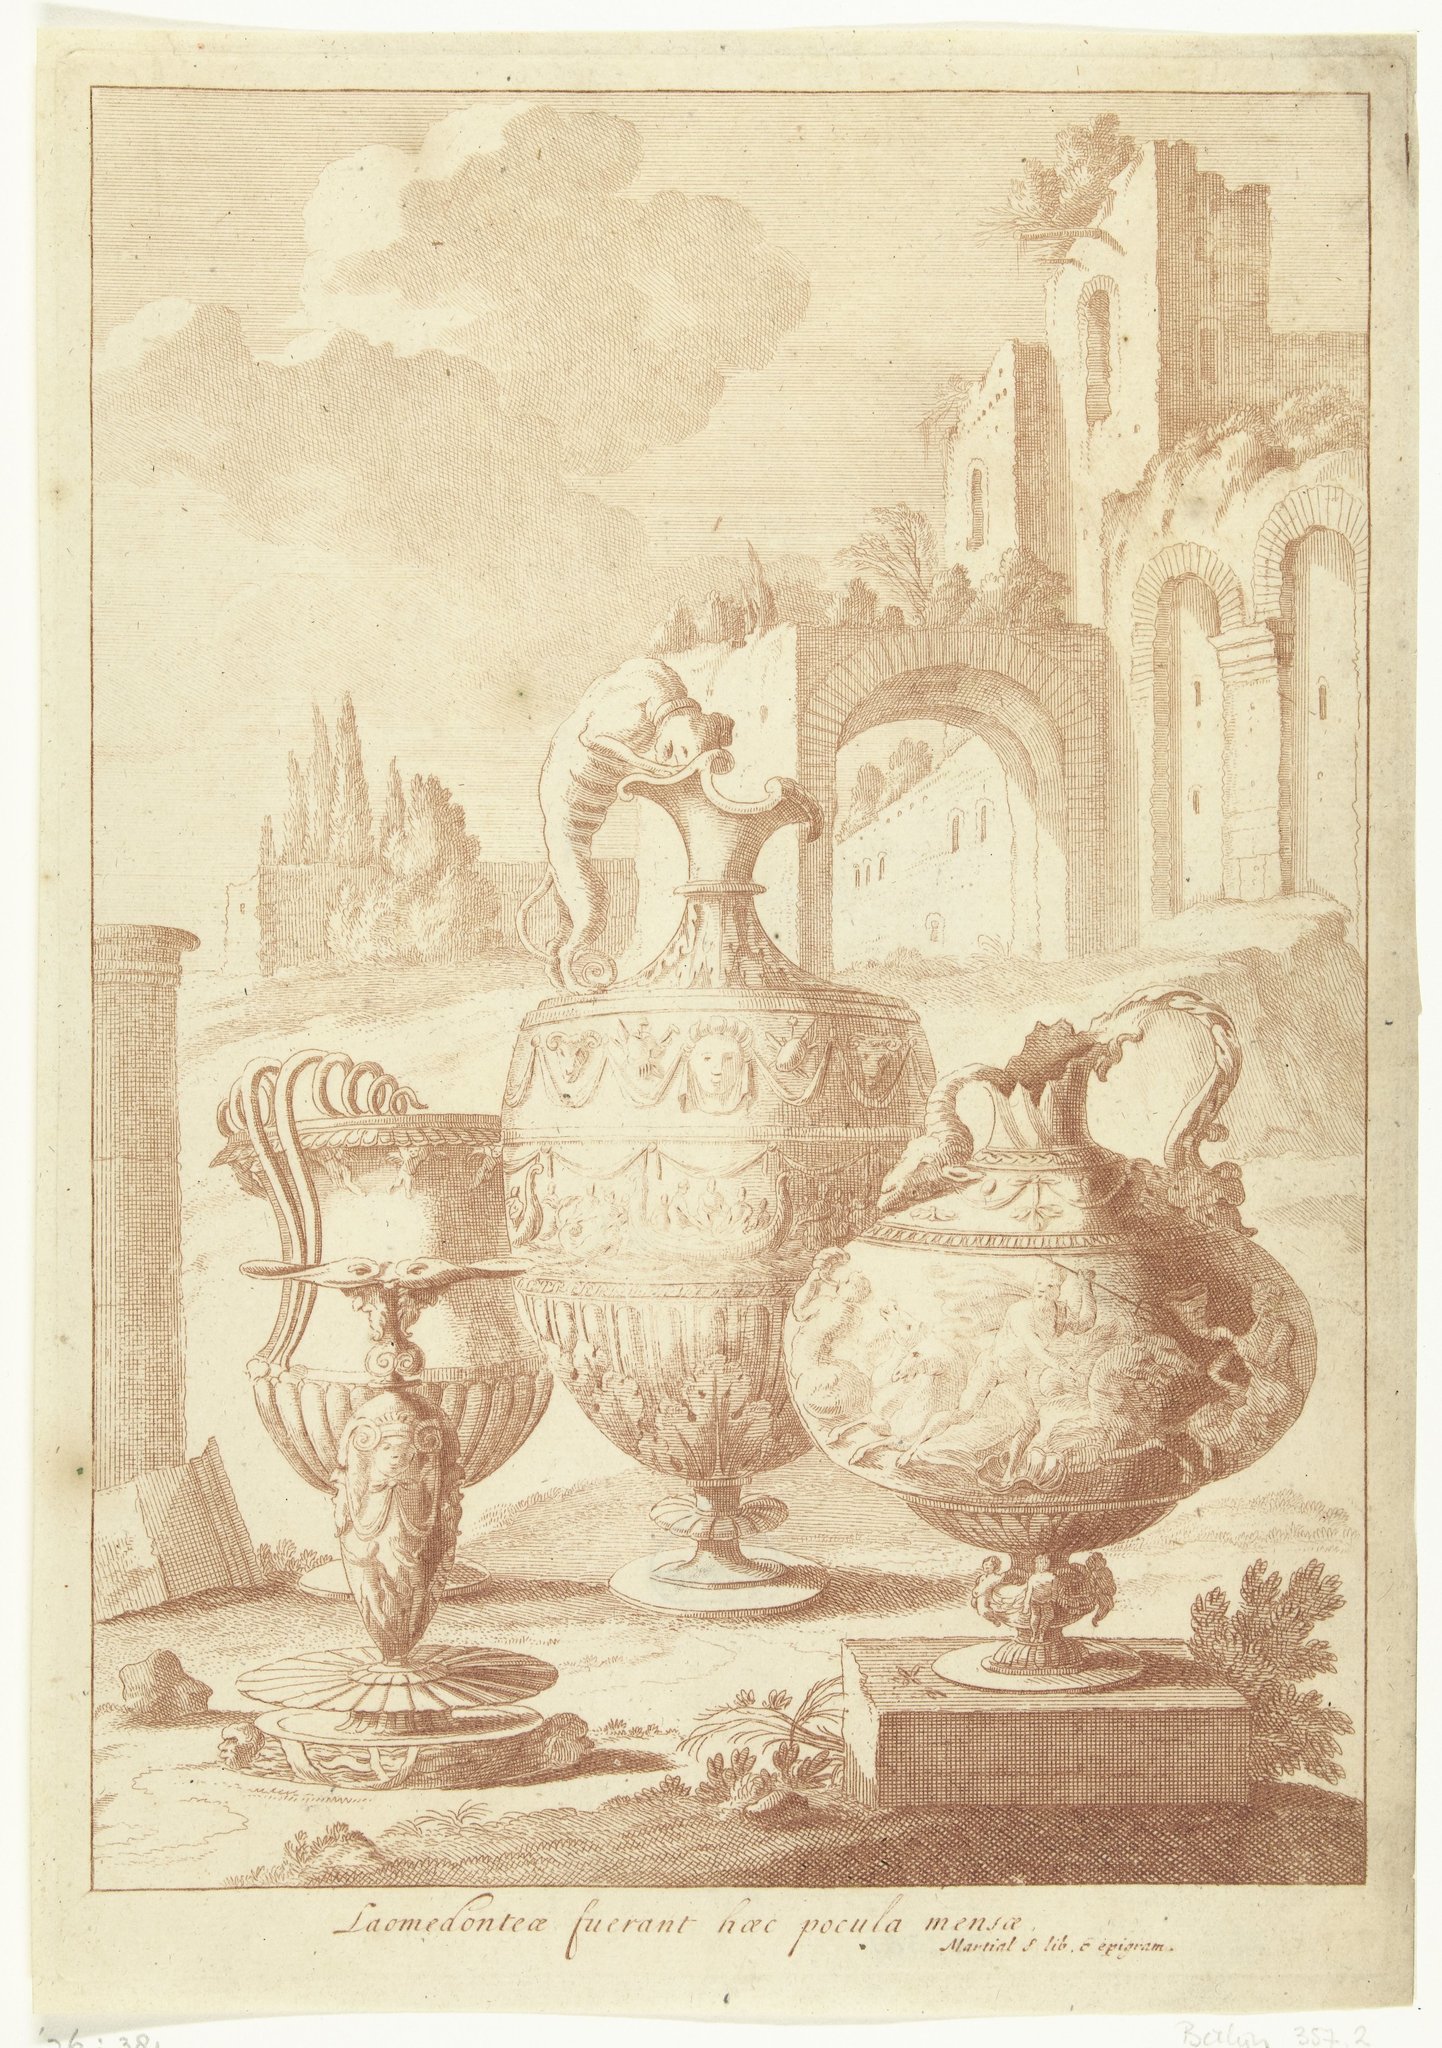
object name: ornament print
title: Vazen en kandelaars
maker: Anonymous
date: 1688-1697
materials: paper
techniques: etching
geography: nijmegen